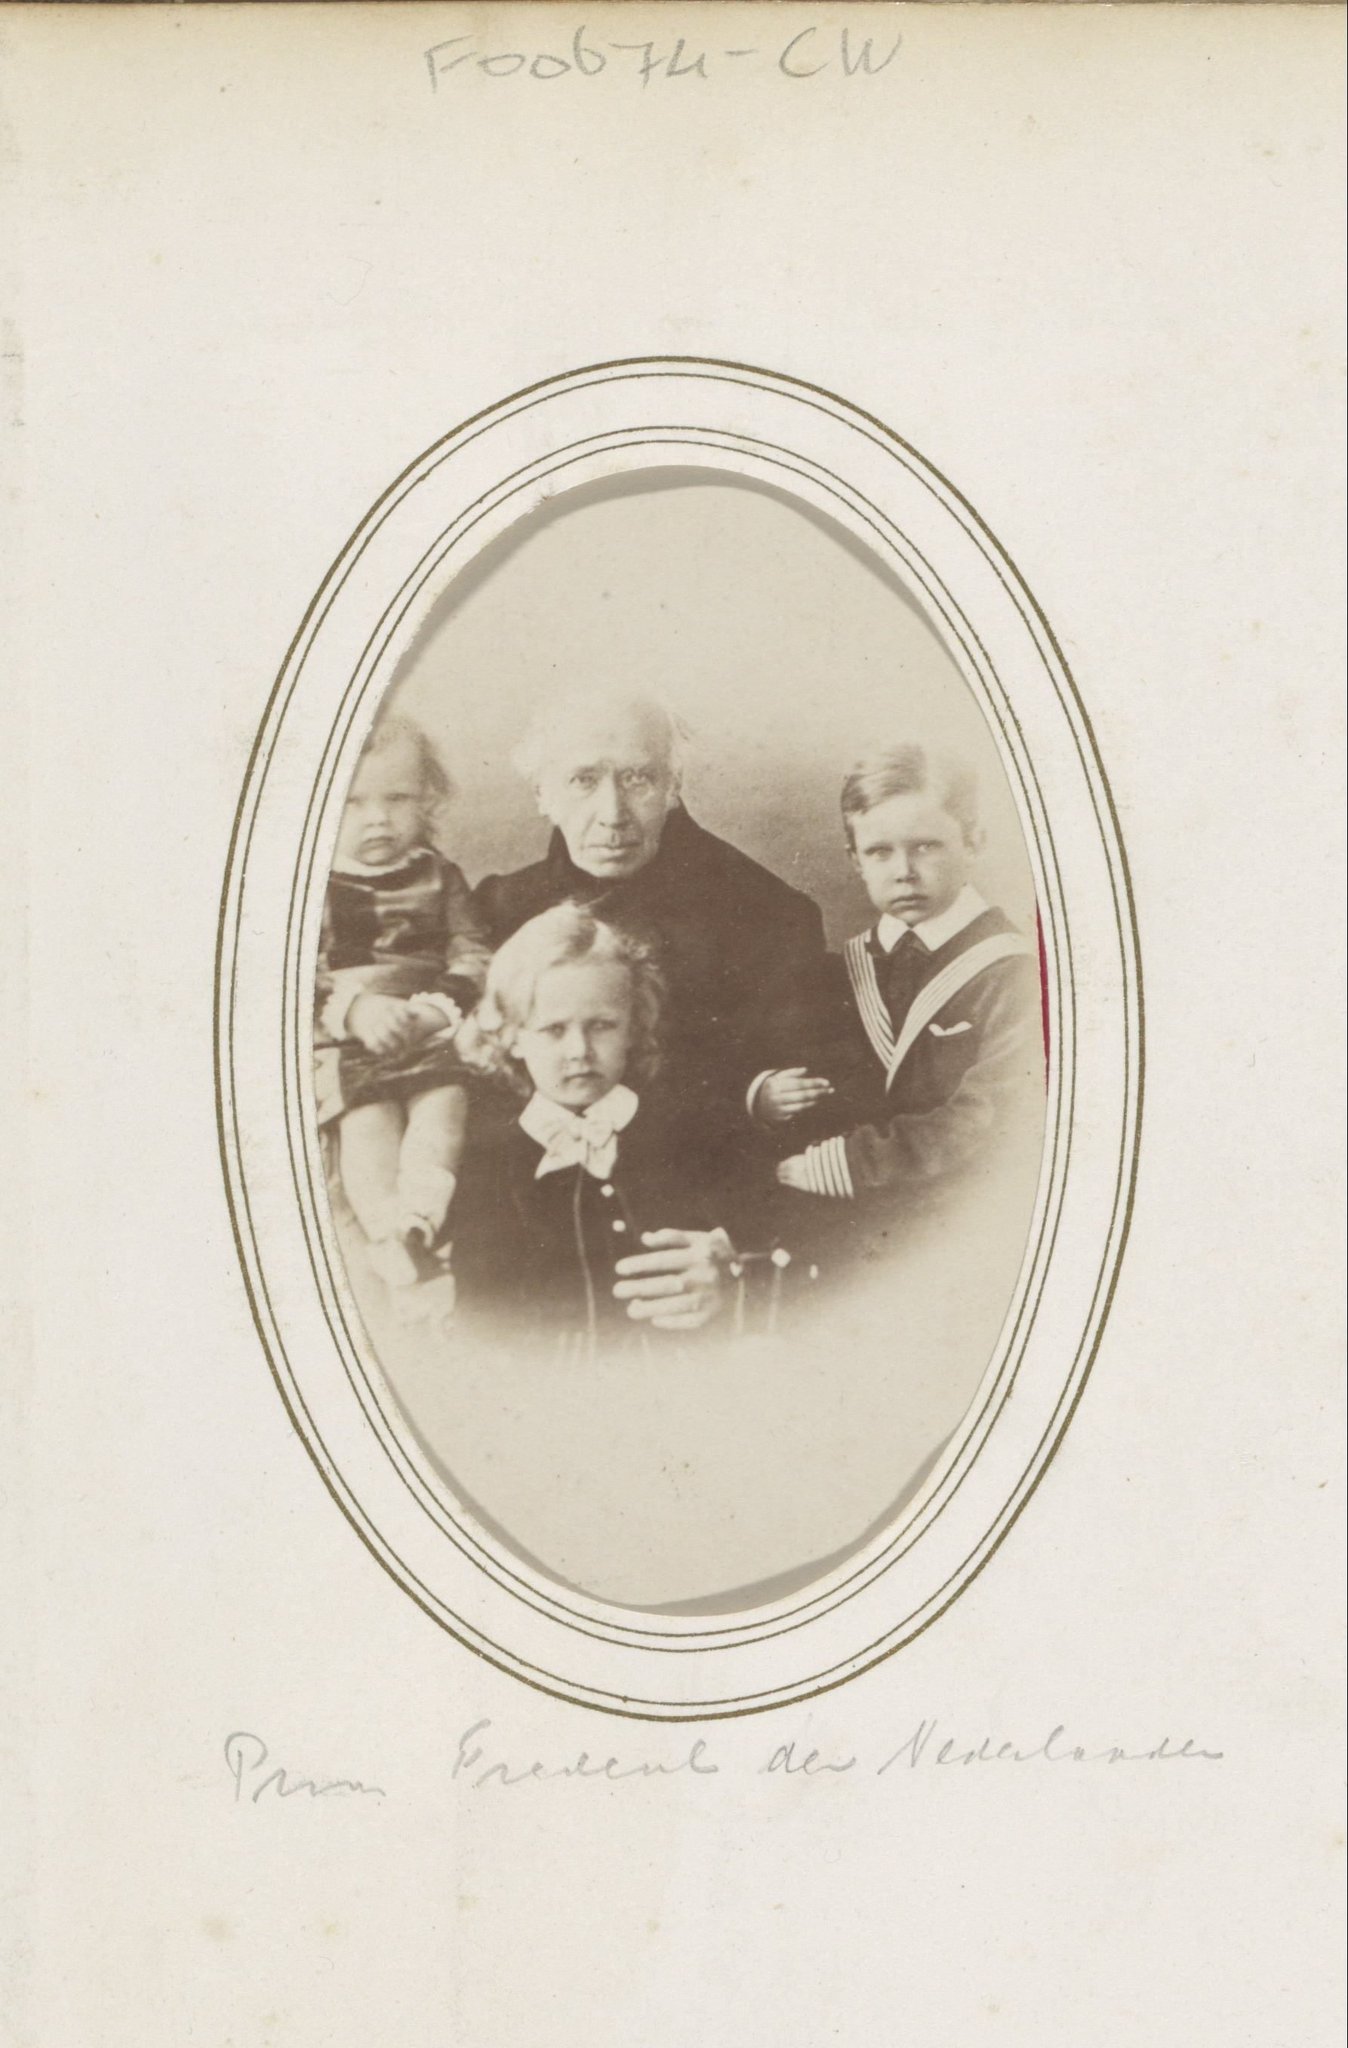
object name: photograph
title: Portret van Frederik, prins der Nederlanden, met zijn kleinkinderen prins Victor, Willem en Frederik van Wied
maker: d. puls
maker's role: fotograaf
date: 1875-1881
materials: cardboard, paper, photographic support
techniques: albumen print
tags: berlin, frederik (prins der nederlanden), prince, child, historical persons, grandparent(s) with grandchild(ren) (family group), clothes, costume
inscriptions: address: ‘Victoria-Hotel, Scheveningen’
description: Onderdeel van Fotoalbum met 123 cartes-de-visite van leden van Europese vorstenhuizen, politici en bekende personen.